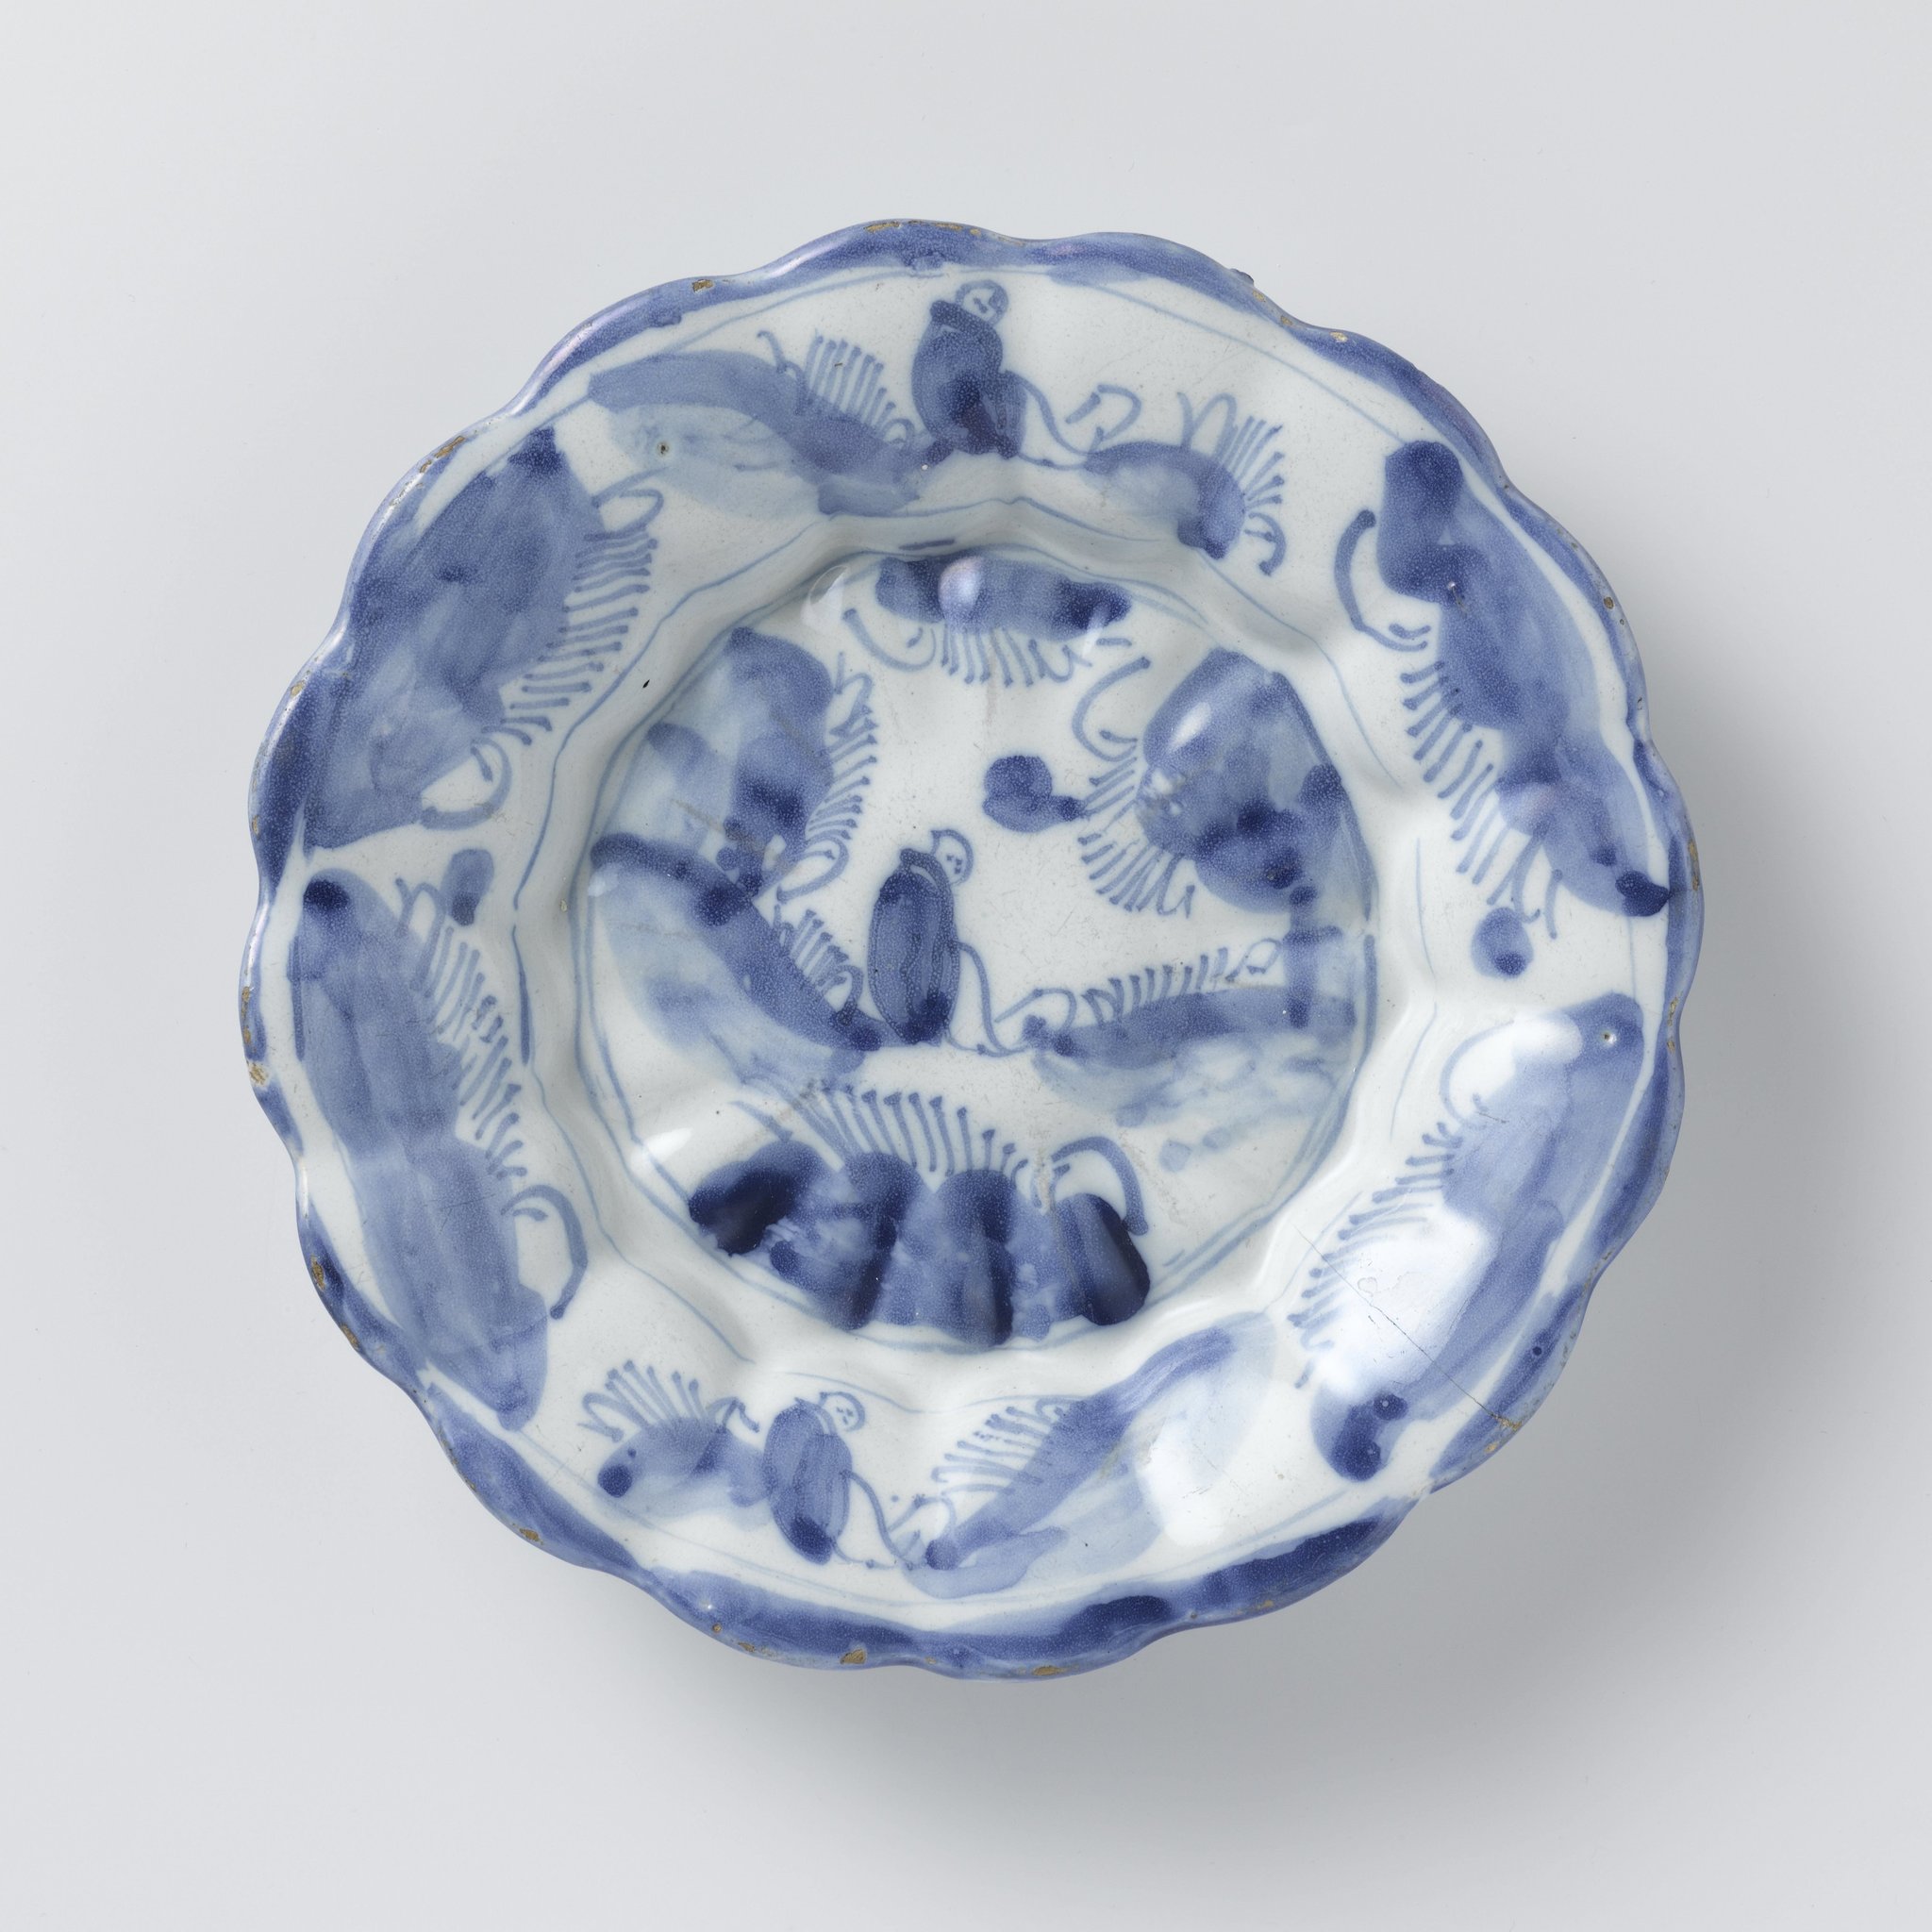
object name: plate dish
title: Bord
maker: Anonymous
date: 1650-1680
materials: earthenware, glaze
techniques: painted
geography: delft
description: Rond bord van blauw beschilderde faience, met een geribde en geschulpte rand. Op het plat is een zittende figuur in een landschap geschilderd en op de rand twee zittende figuren. De beschildering is grof en vluchtig uitgevoerd.